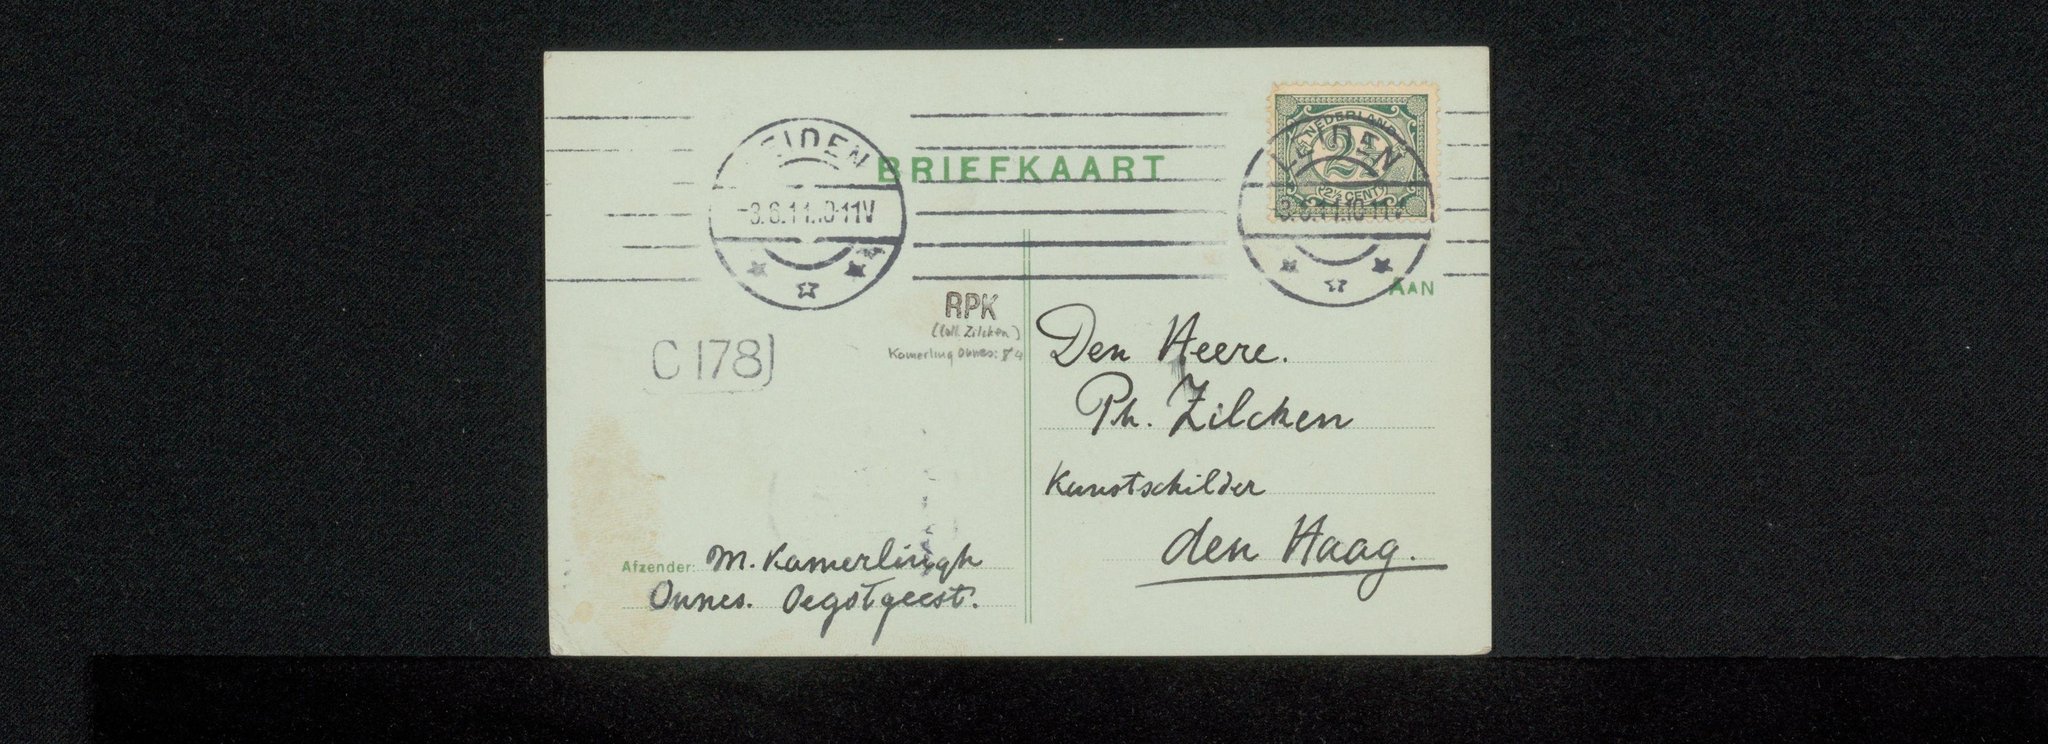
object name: postcard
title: Briefkaart aan Philip Zilcken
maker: menso kamerlingh onnes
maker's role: painter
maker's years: 1860-1925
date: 1911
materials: cardboard, ink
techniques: pen, writing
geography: oegstgeest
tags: painter, draughtsman, philip zilcken, the graphic arts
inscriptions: collector's mark: ‘RPK’